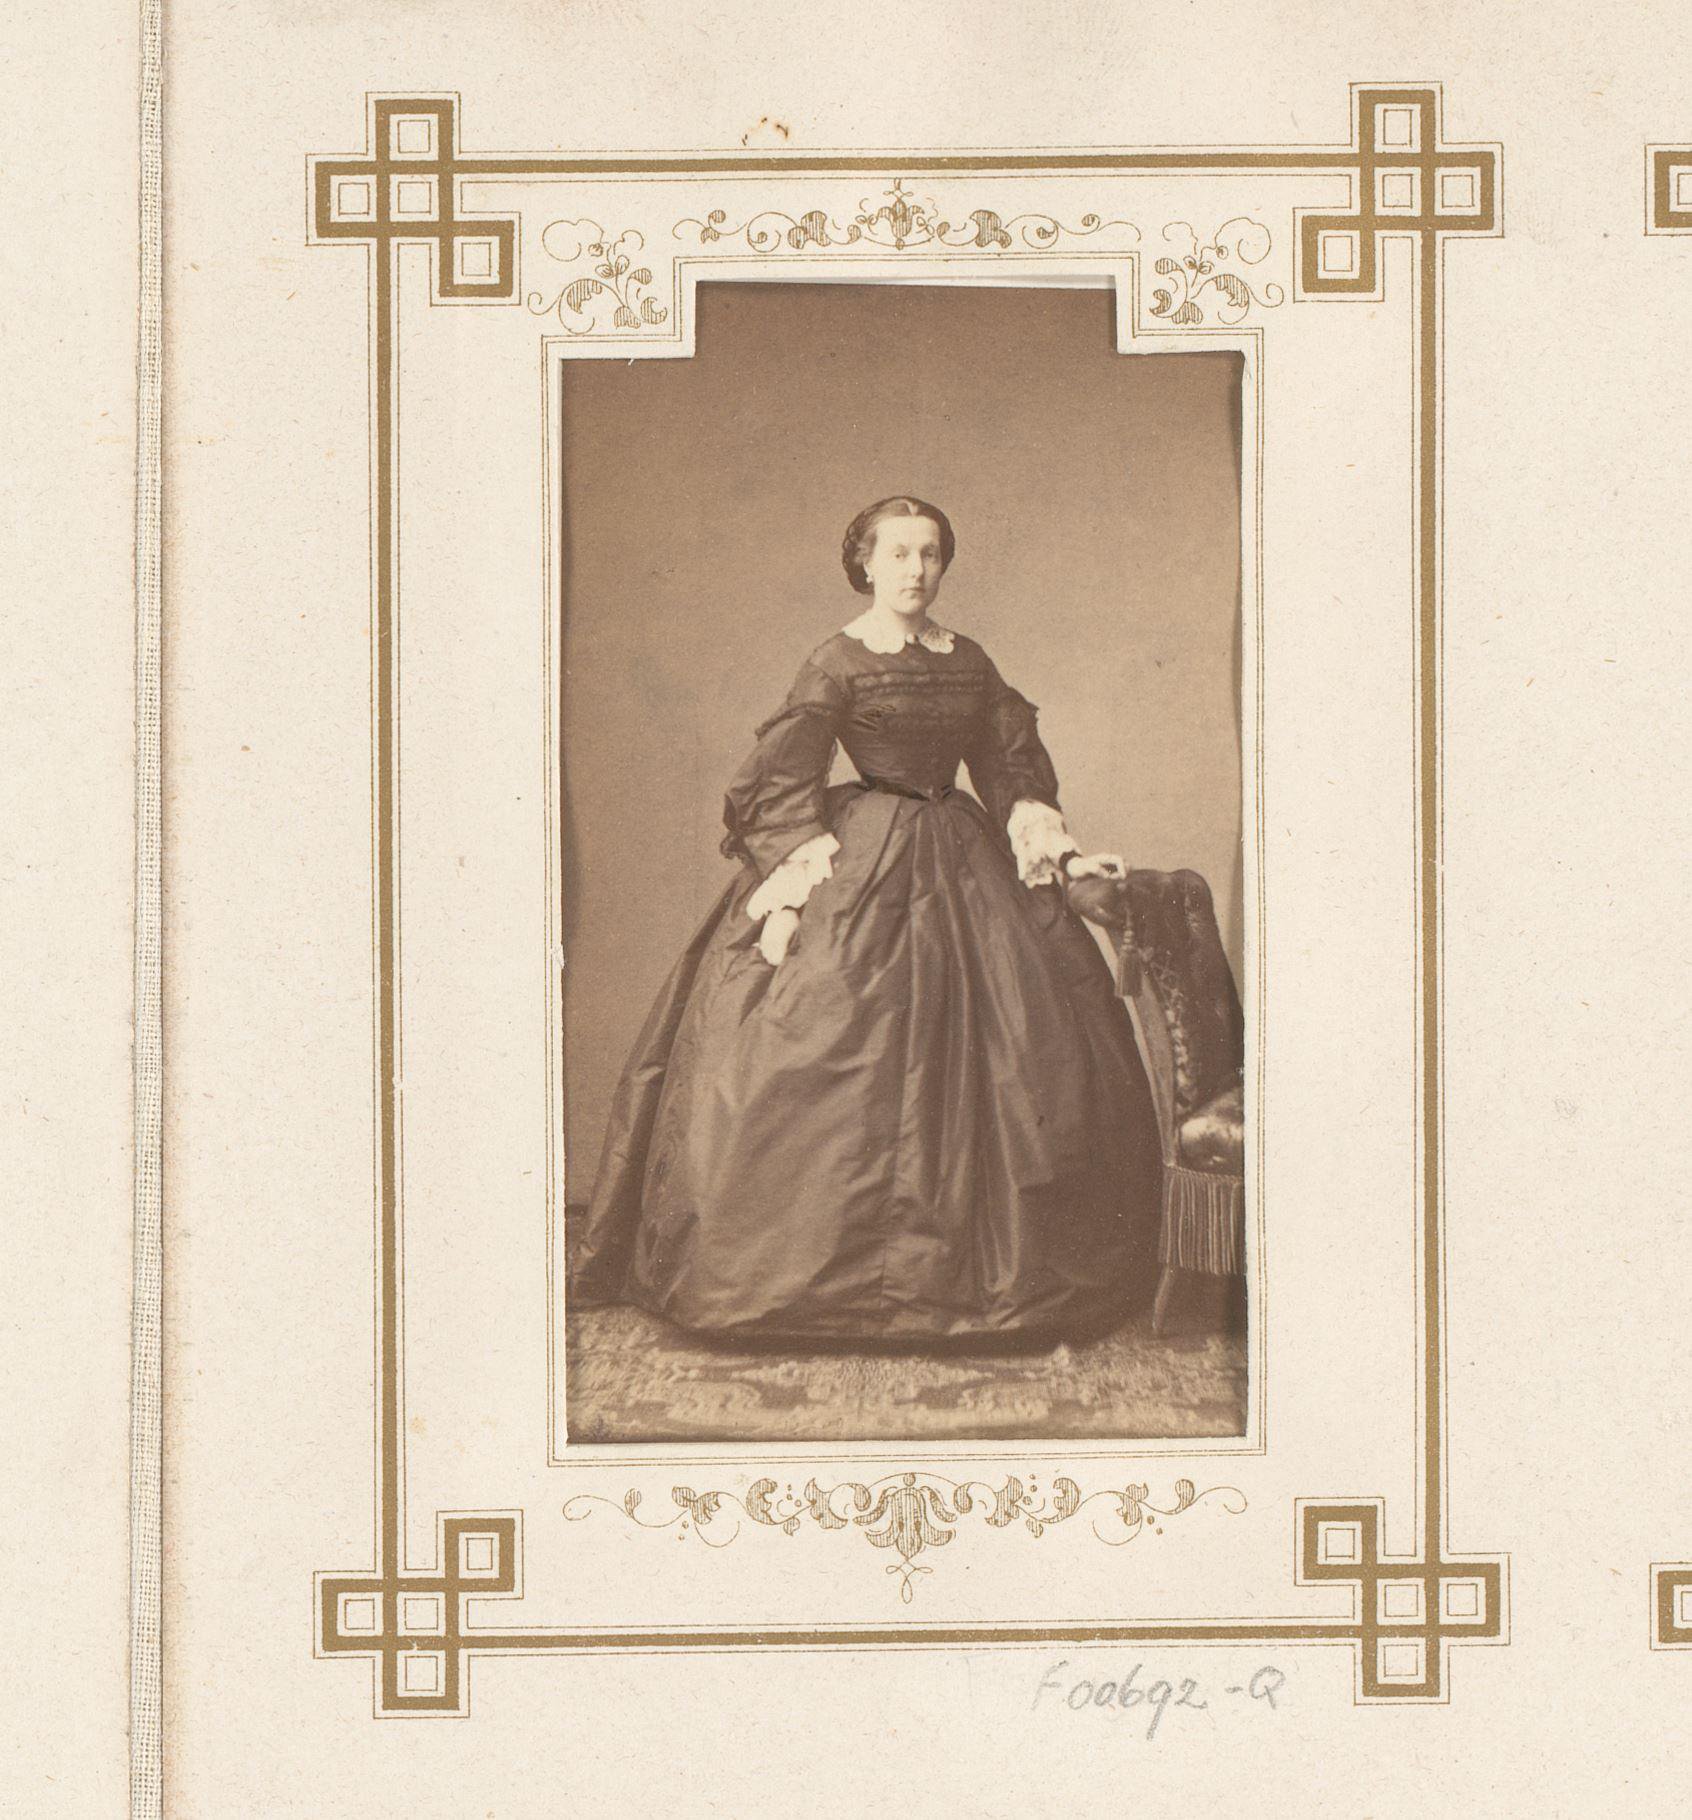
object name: album leaf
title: Portret van een vrouw bij een stoel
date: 1860-1870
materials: cardboard, photographic support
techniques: albumen print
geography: brussels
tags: historical persons - bb - woman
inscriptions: inscription: ‘32 Rue des Fripiers’